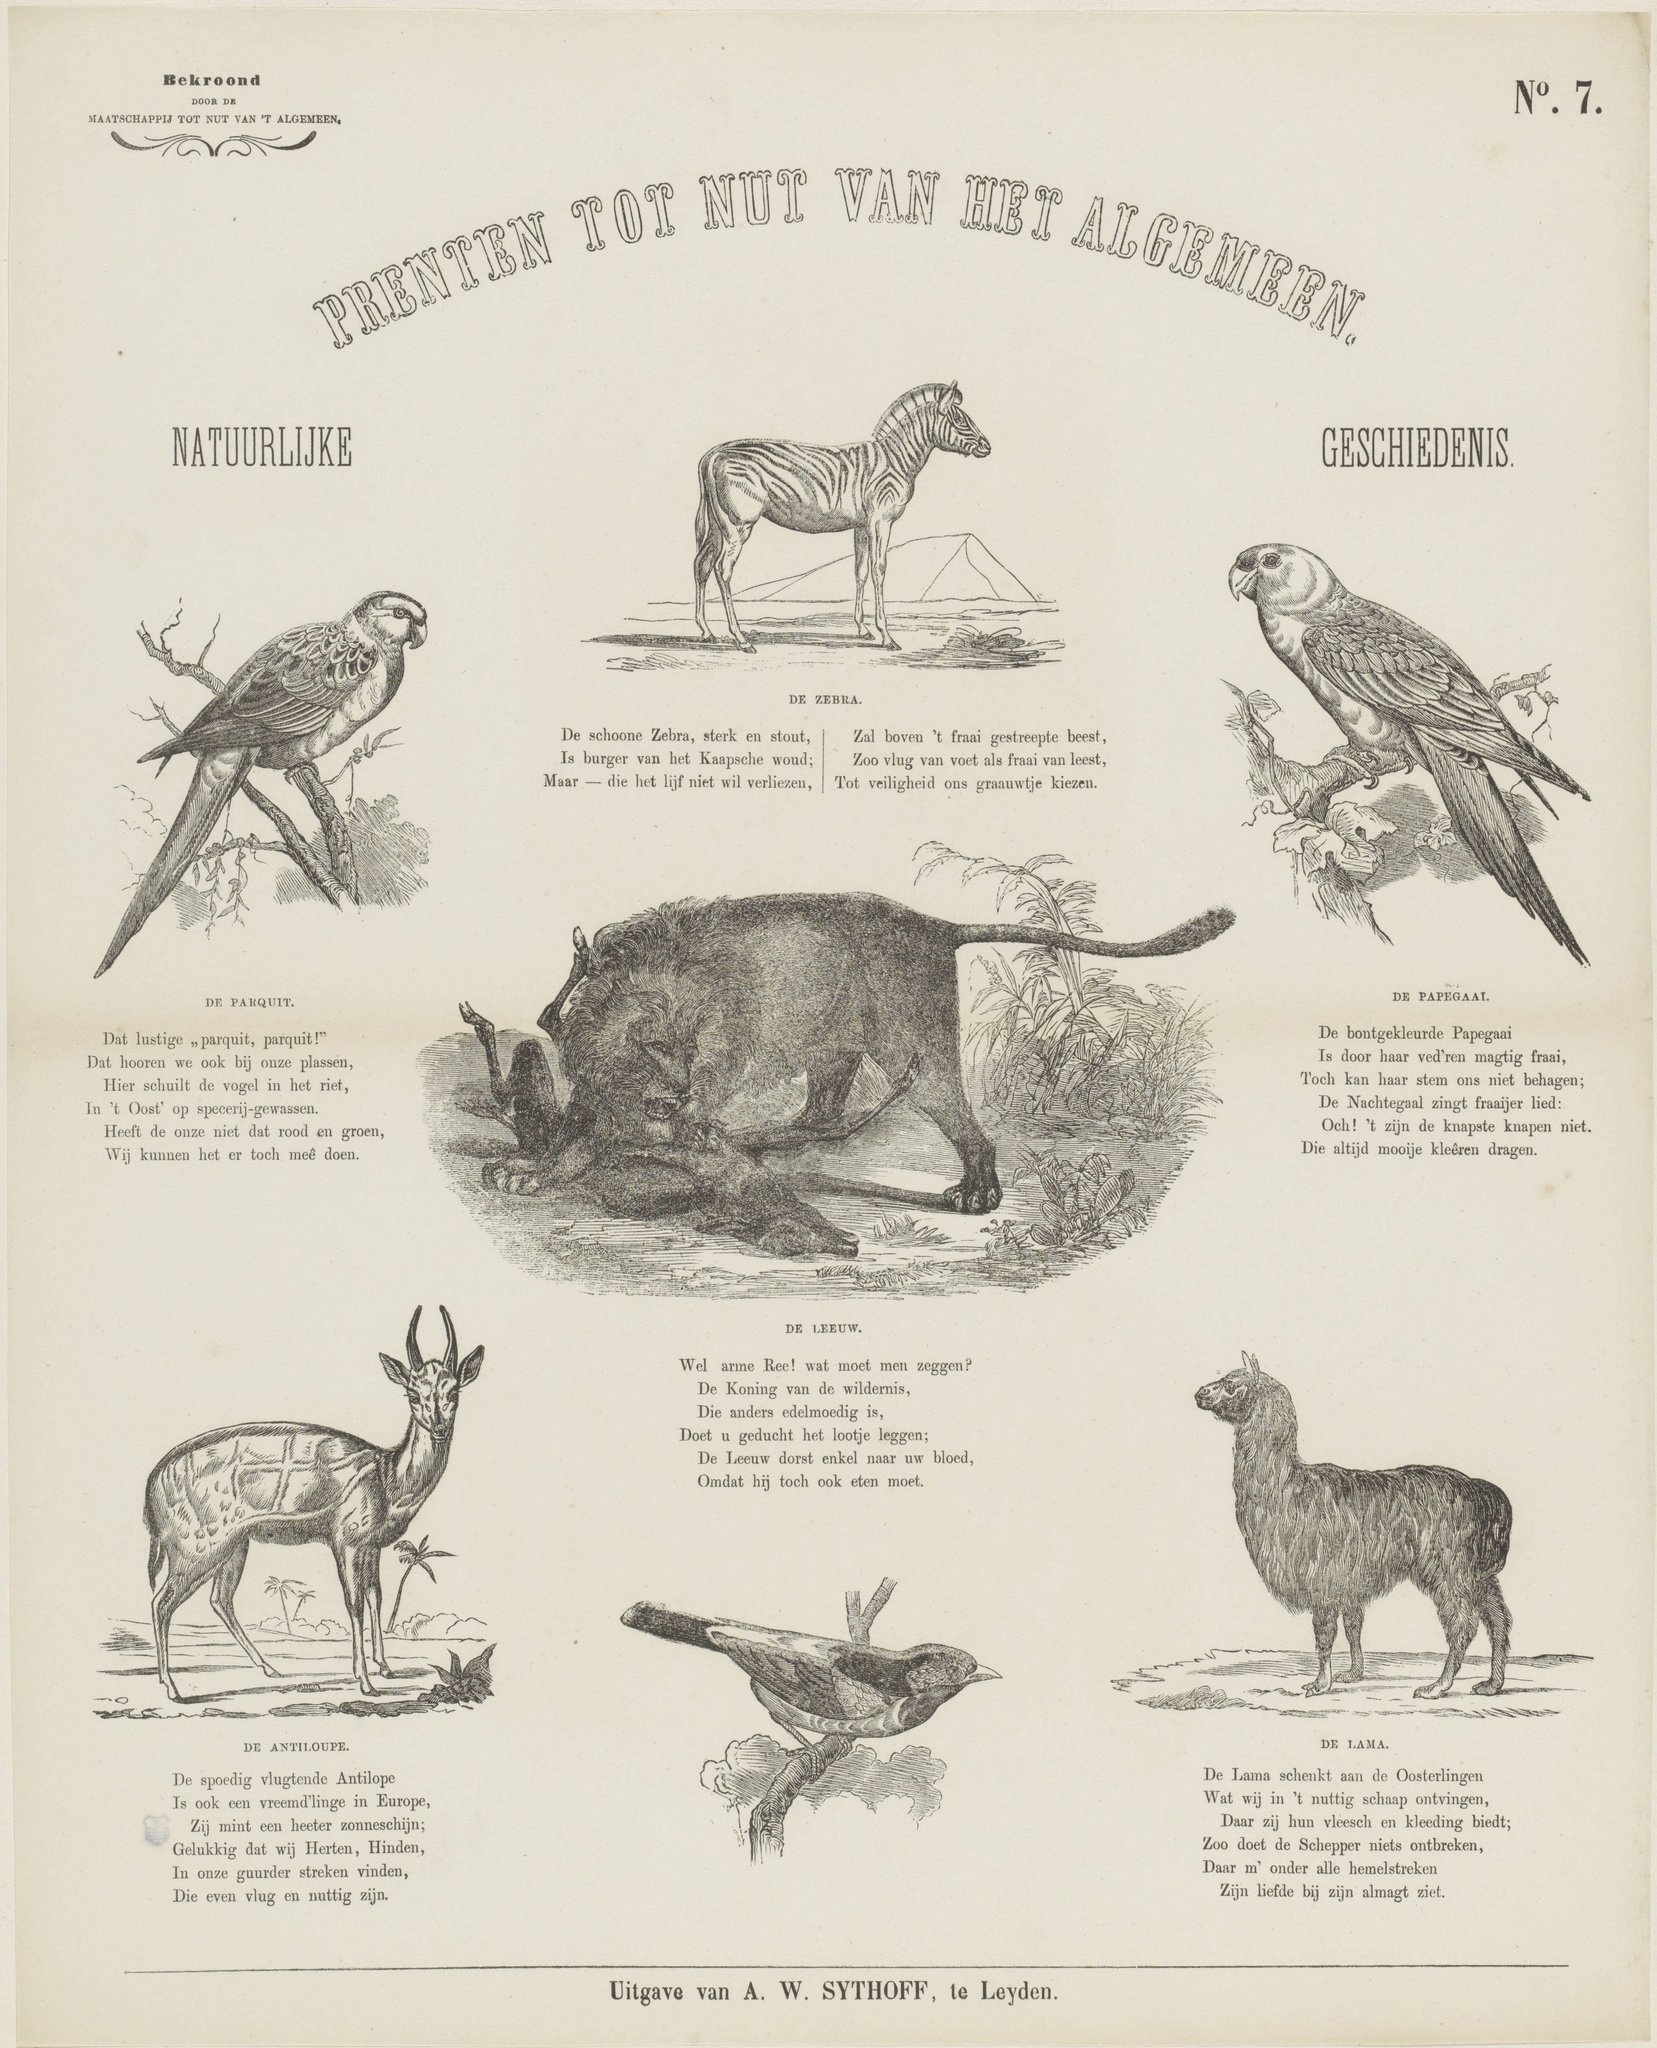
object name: print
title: Natuurlijke geschiedenis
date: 1861-1929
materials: paper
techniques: letterpress printing, engraving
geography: leiden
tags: animals, birds, ornamental birds: parrot, beasts of prey, predatory animals: lion, hoofed animals: antelope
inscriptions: collector's mark: Lugt 2760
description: Blad met 7 voorstellingen van dieren, zoals een parkiet, een zebra en een leeuw. Onder enkele voorstellingen een titel en een vers. Genummerd rechtsboven: No. 7. Linksboven: Bekroond door de Maatschappij tot Nut van 't Algemeen.